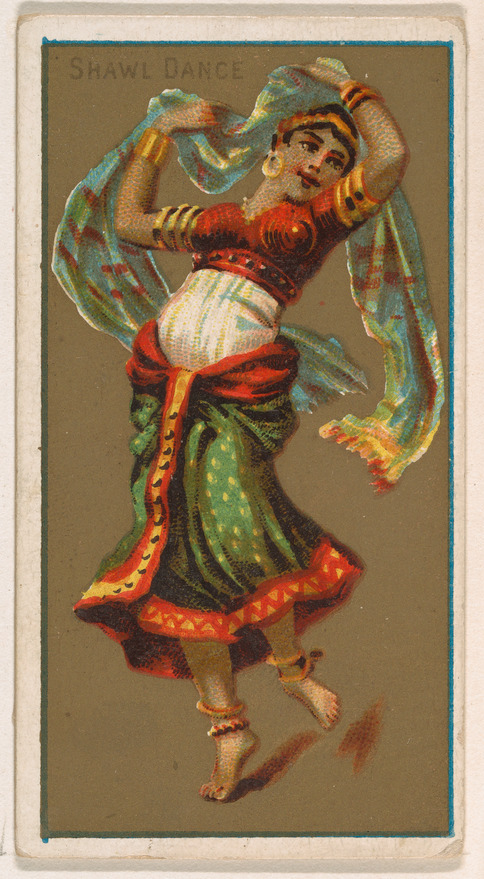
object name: print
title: Shawl Dance, from National Dances (N225, Type 1) issued by Kinney Bros.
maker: kinney brothers tobacco company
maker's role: publisher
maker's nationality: american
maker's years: 1869-2011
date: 1889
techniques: color lithograph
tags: women,dancing